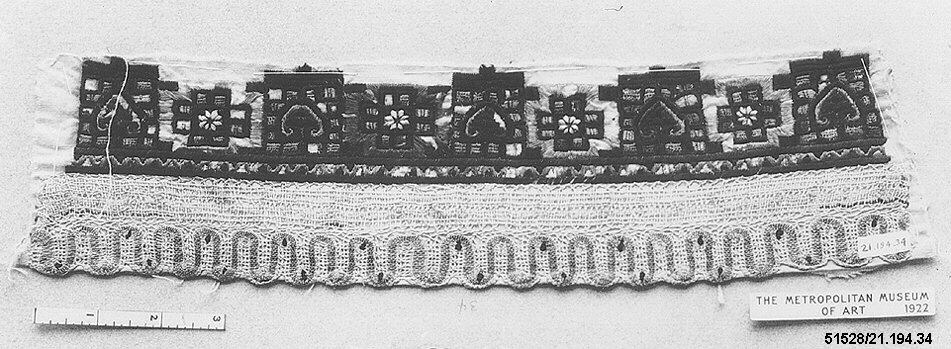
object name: cap border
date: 1801-1900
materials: linen, silk